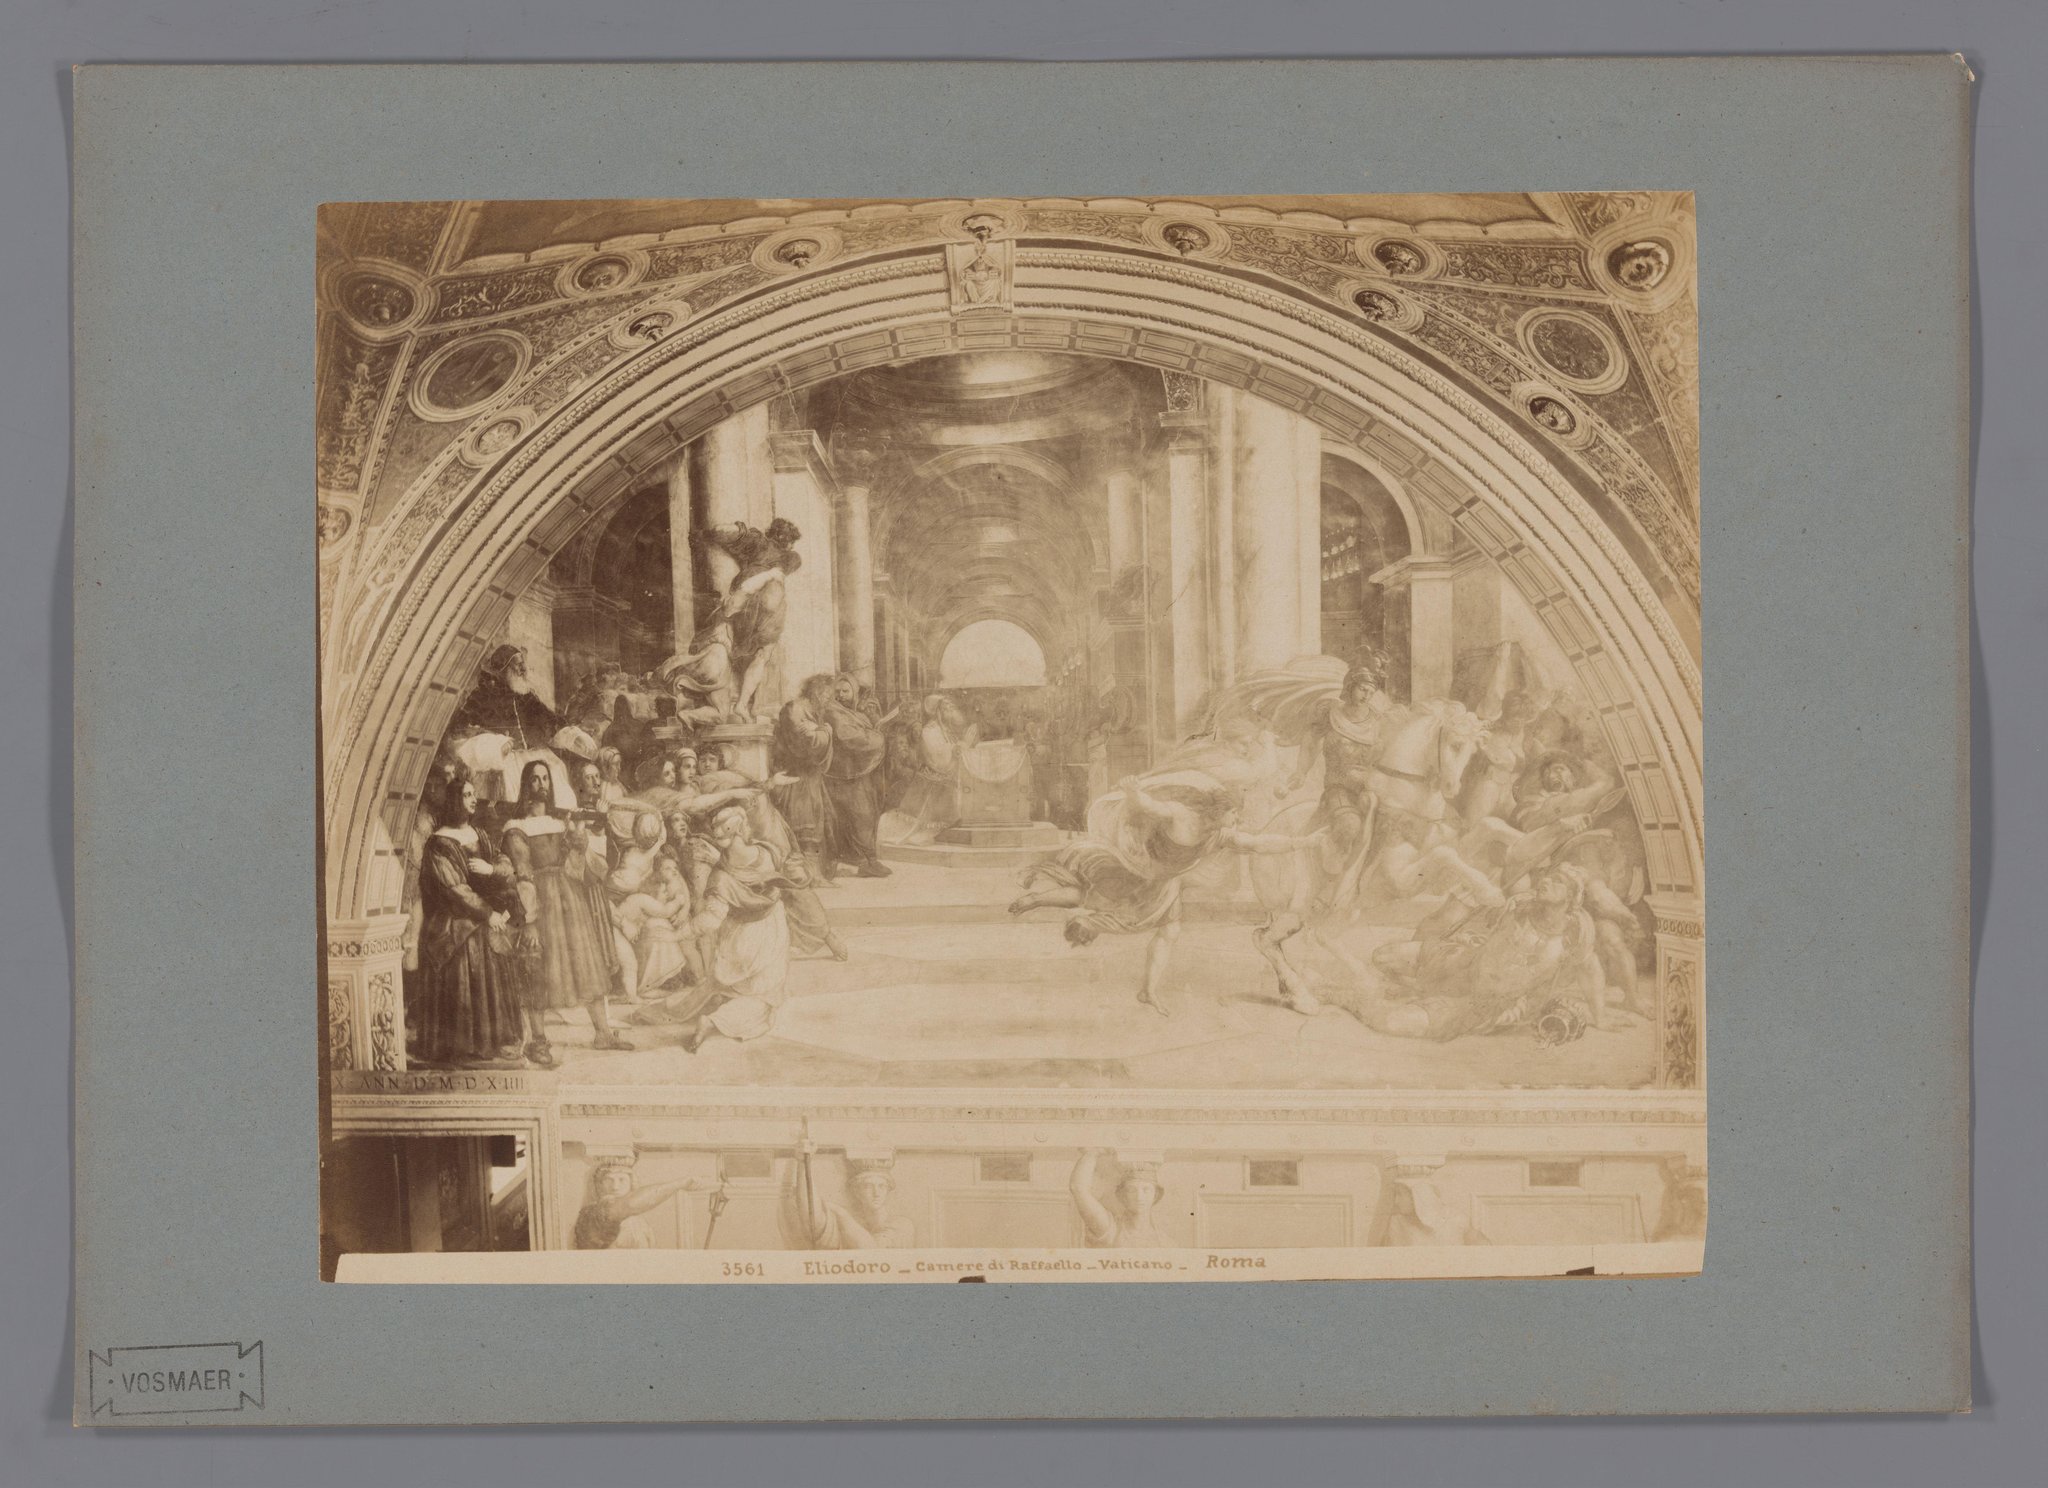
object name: photograph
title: Fotoreproductie van het fresco Stanze d'Eliodoro door Rafaël in de Camere di Raffaello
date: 1851-1900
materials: cardboard, paper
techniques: albumen print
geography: rome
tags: picture, painting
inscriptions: number: ‘3561’, collector's mark: ‘VOSMAER’